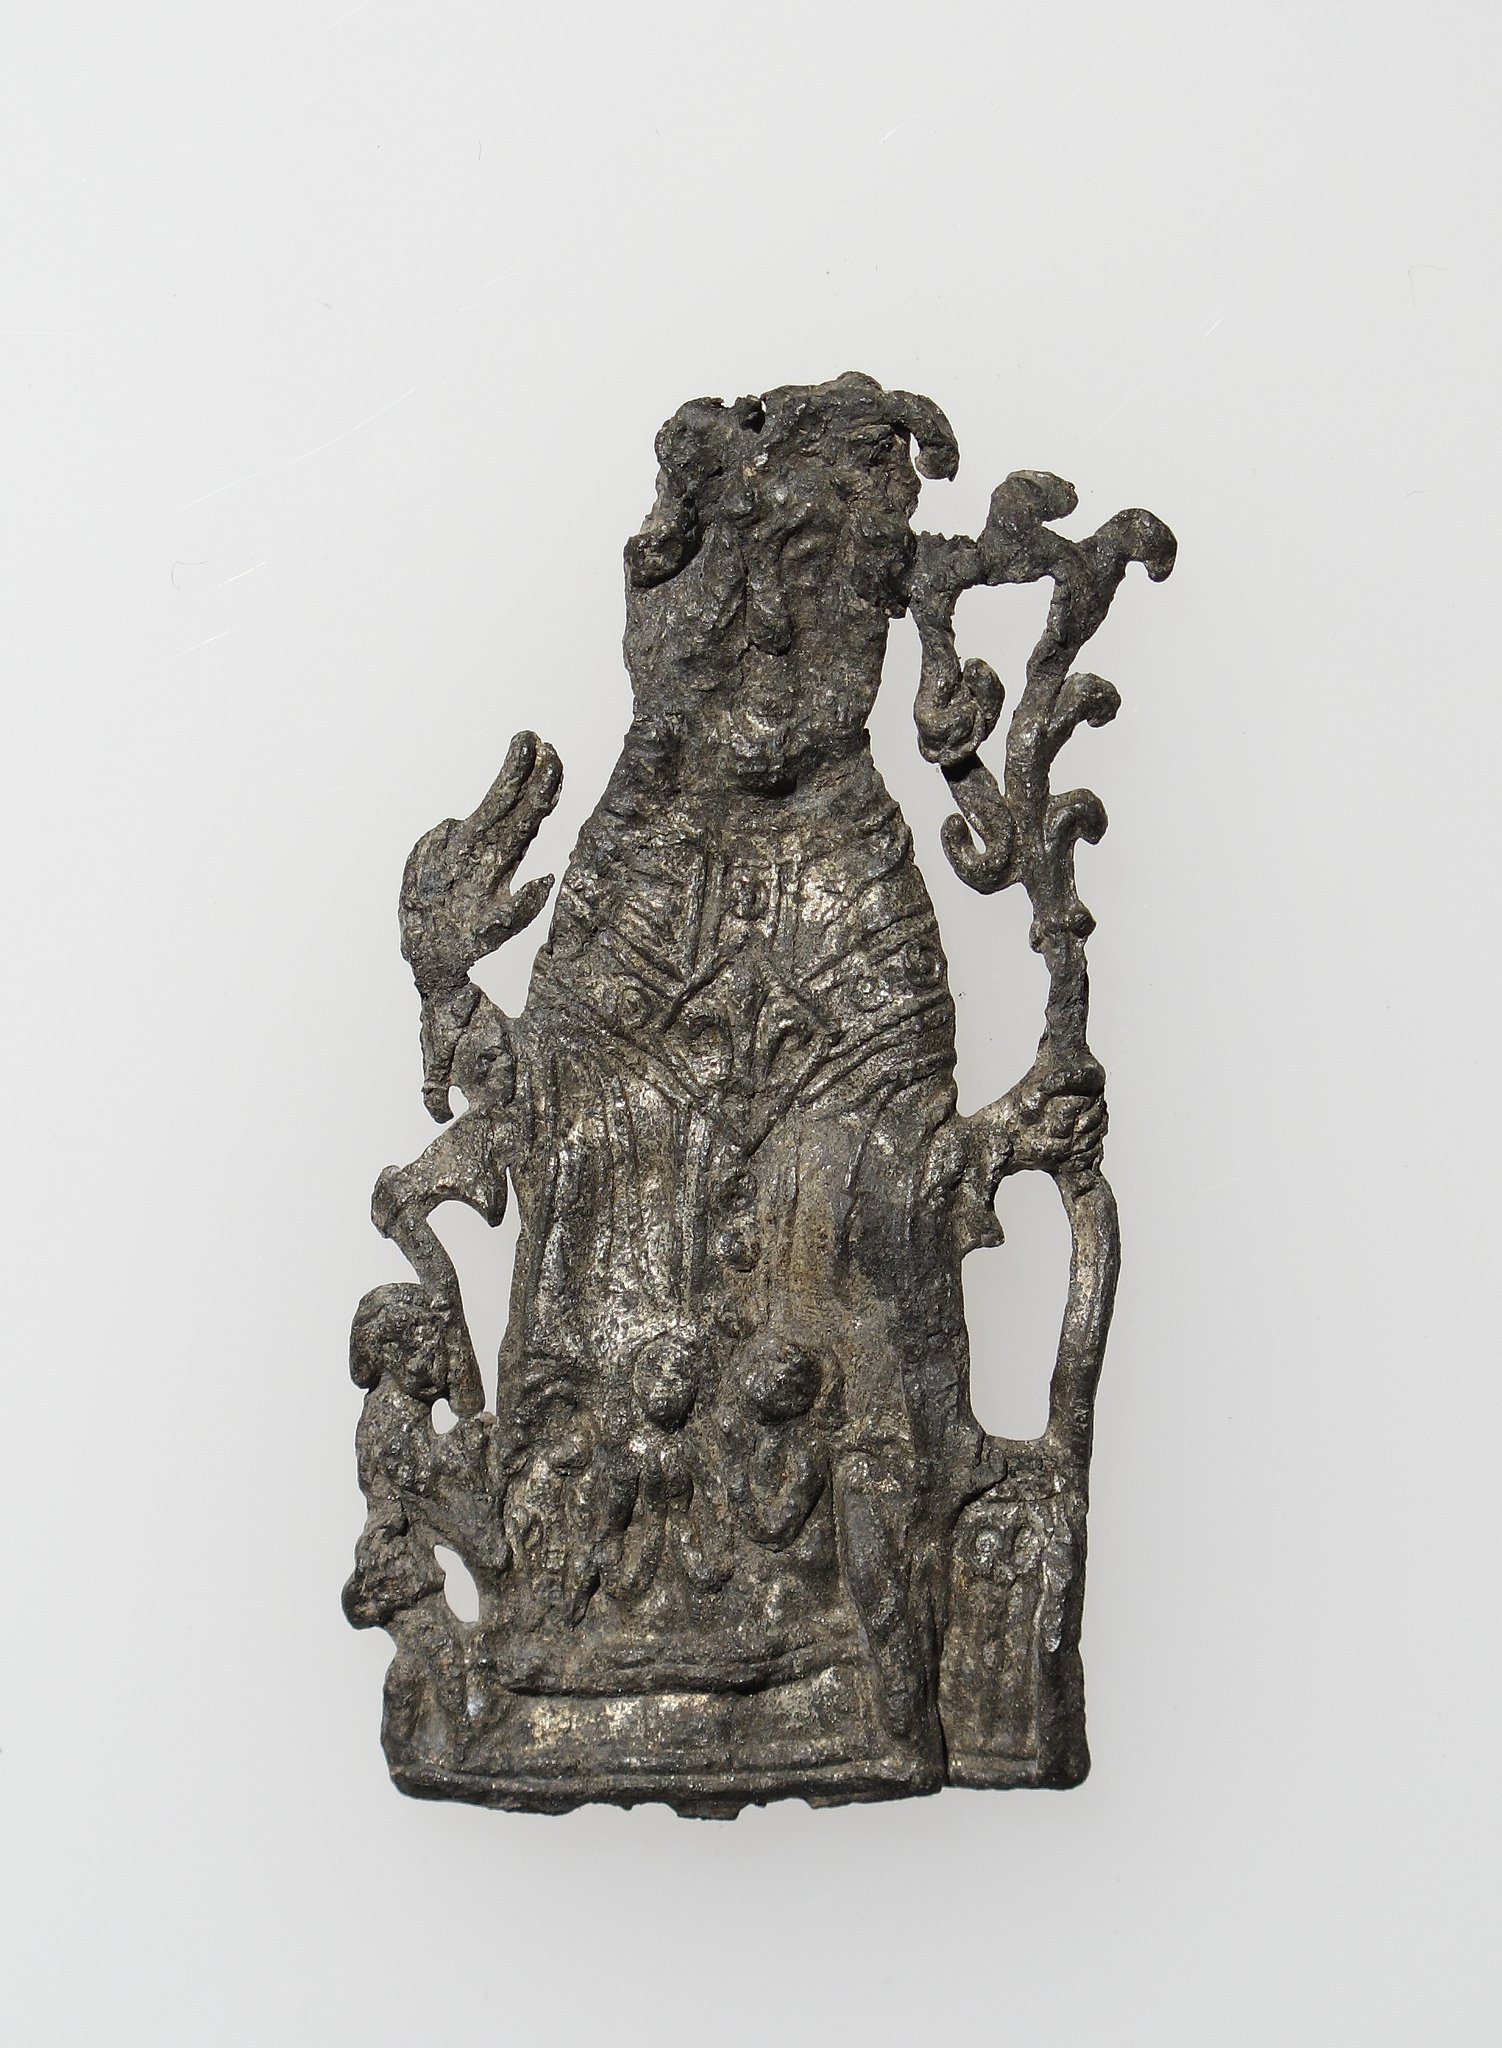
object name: pilgrim's badge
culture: french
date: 1301-1600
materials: lead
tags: saints